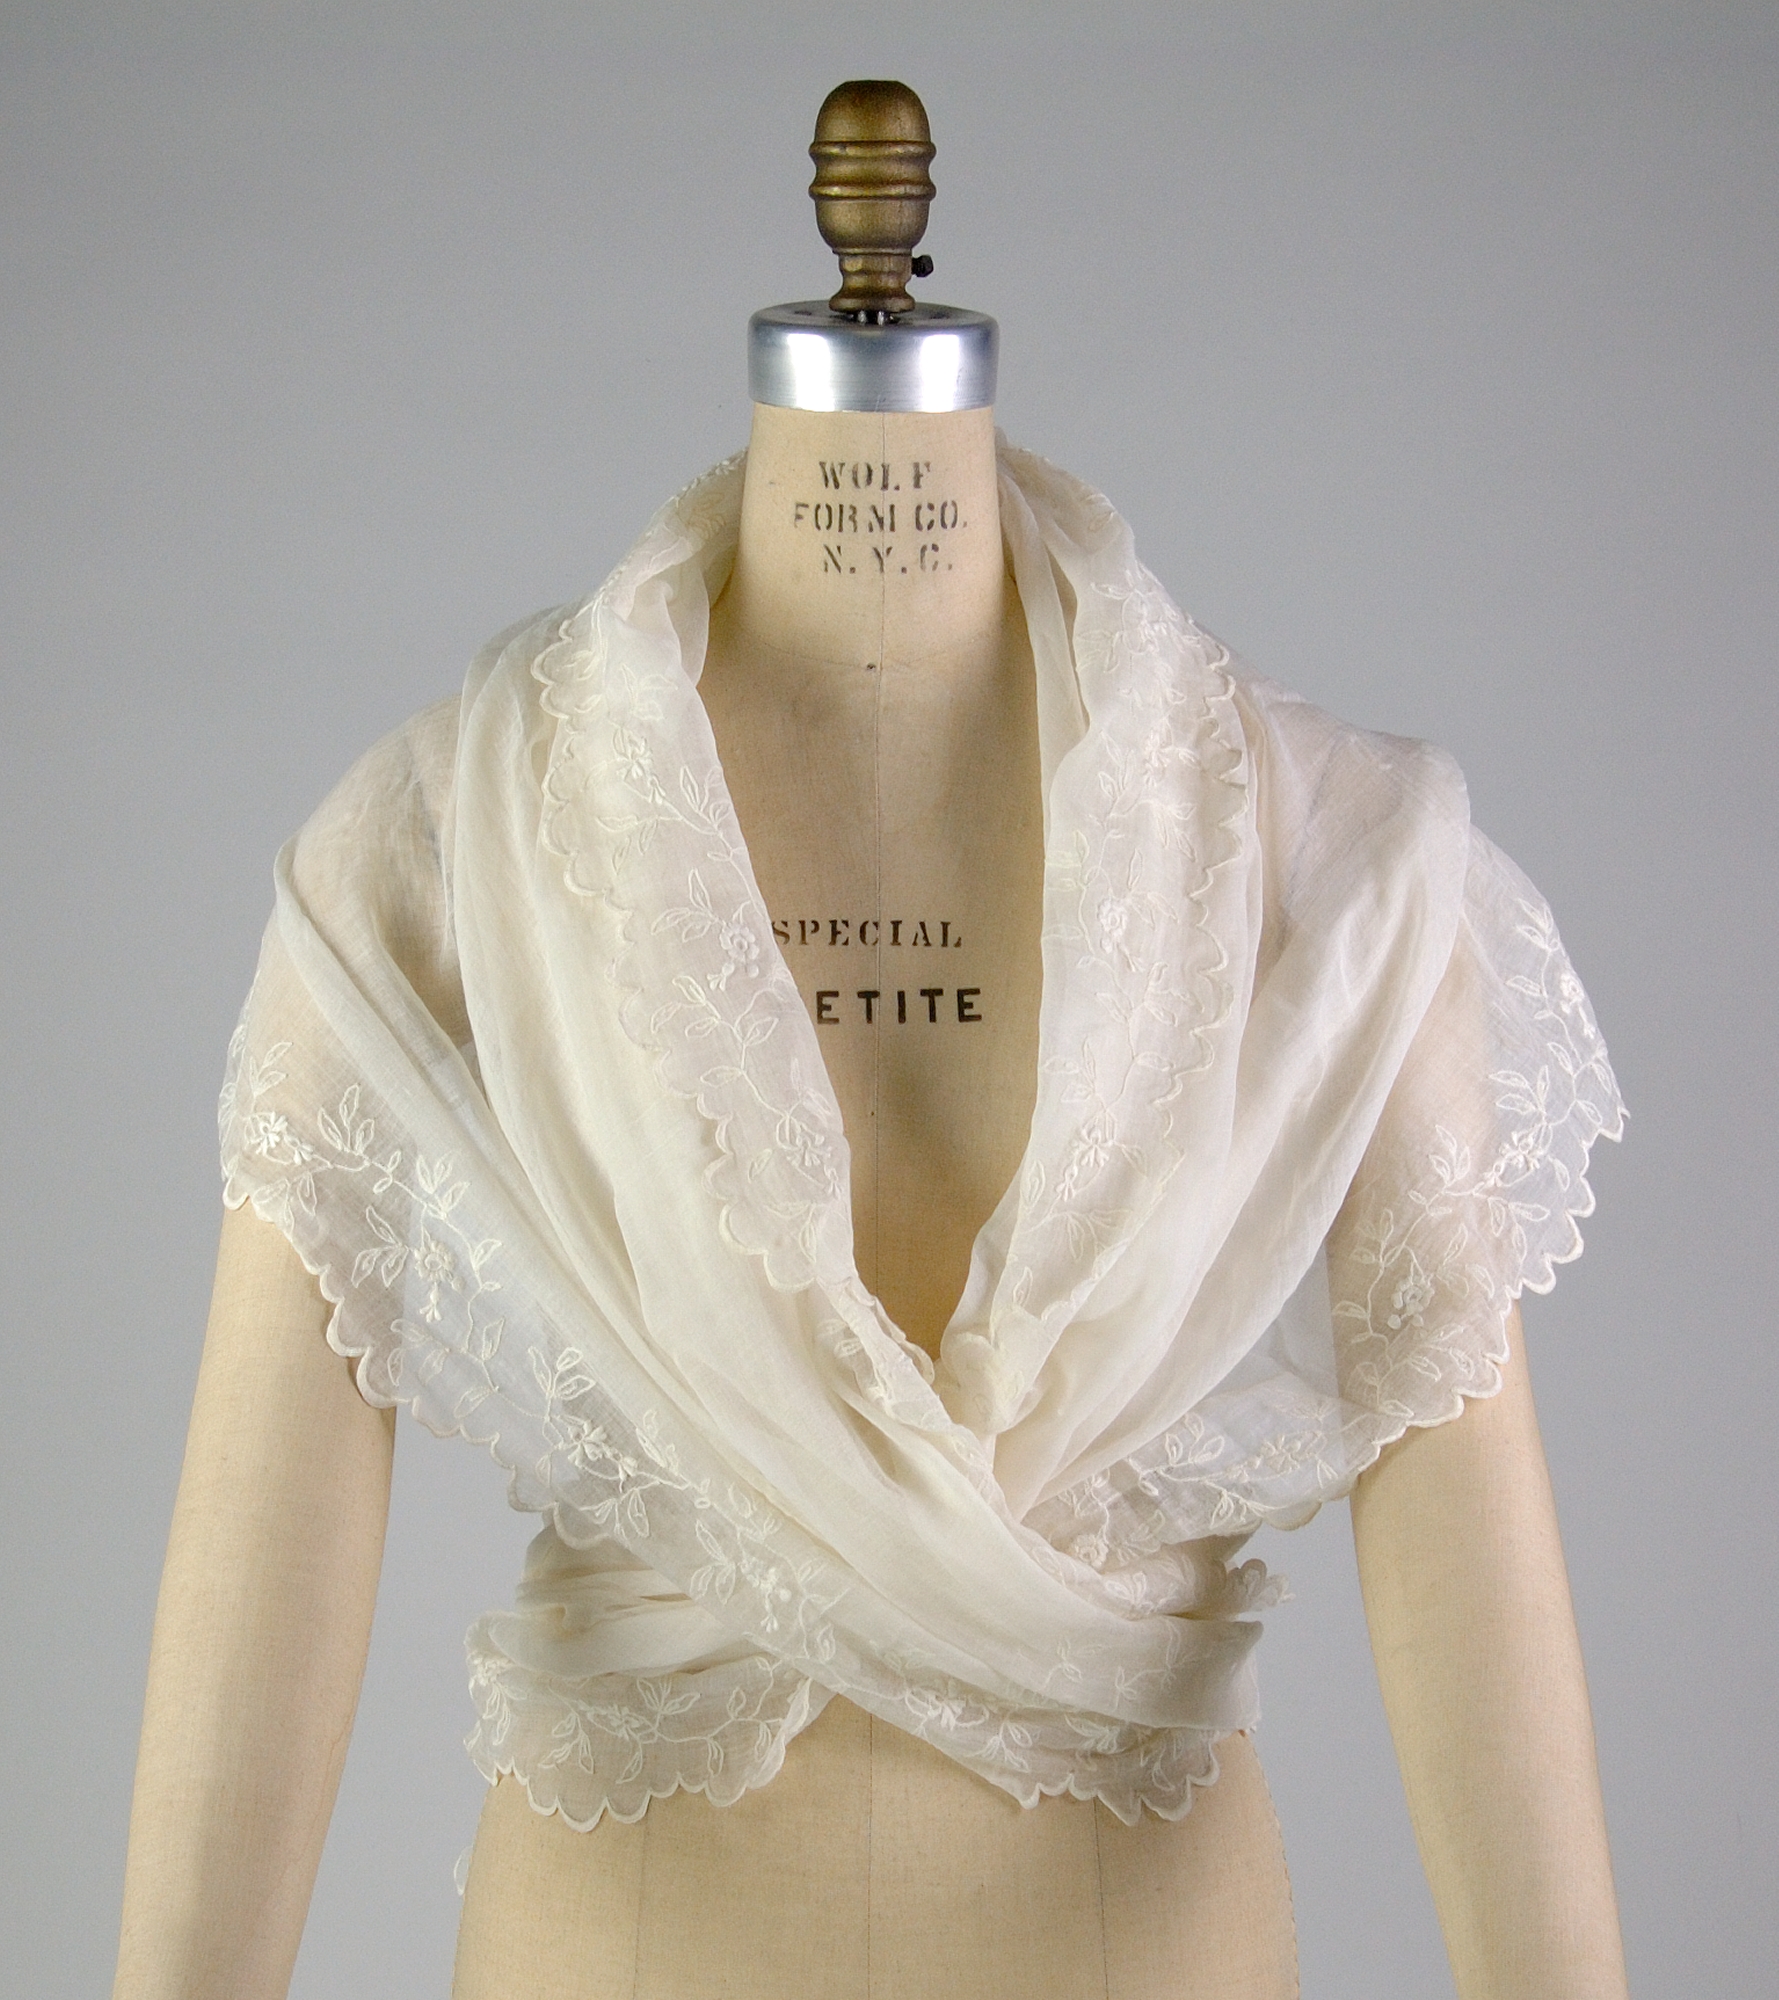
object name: fichu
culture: french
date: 1793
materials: cotton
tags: flowers